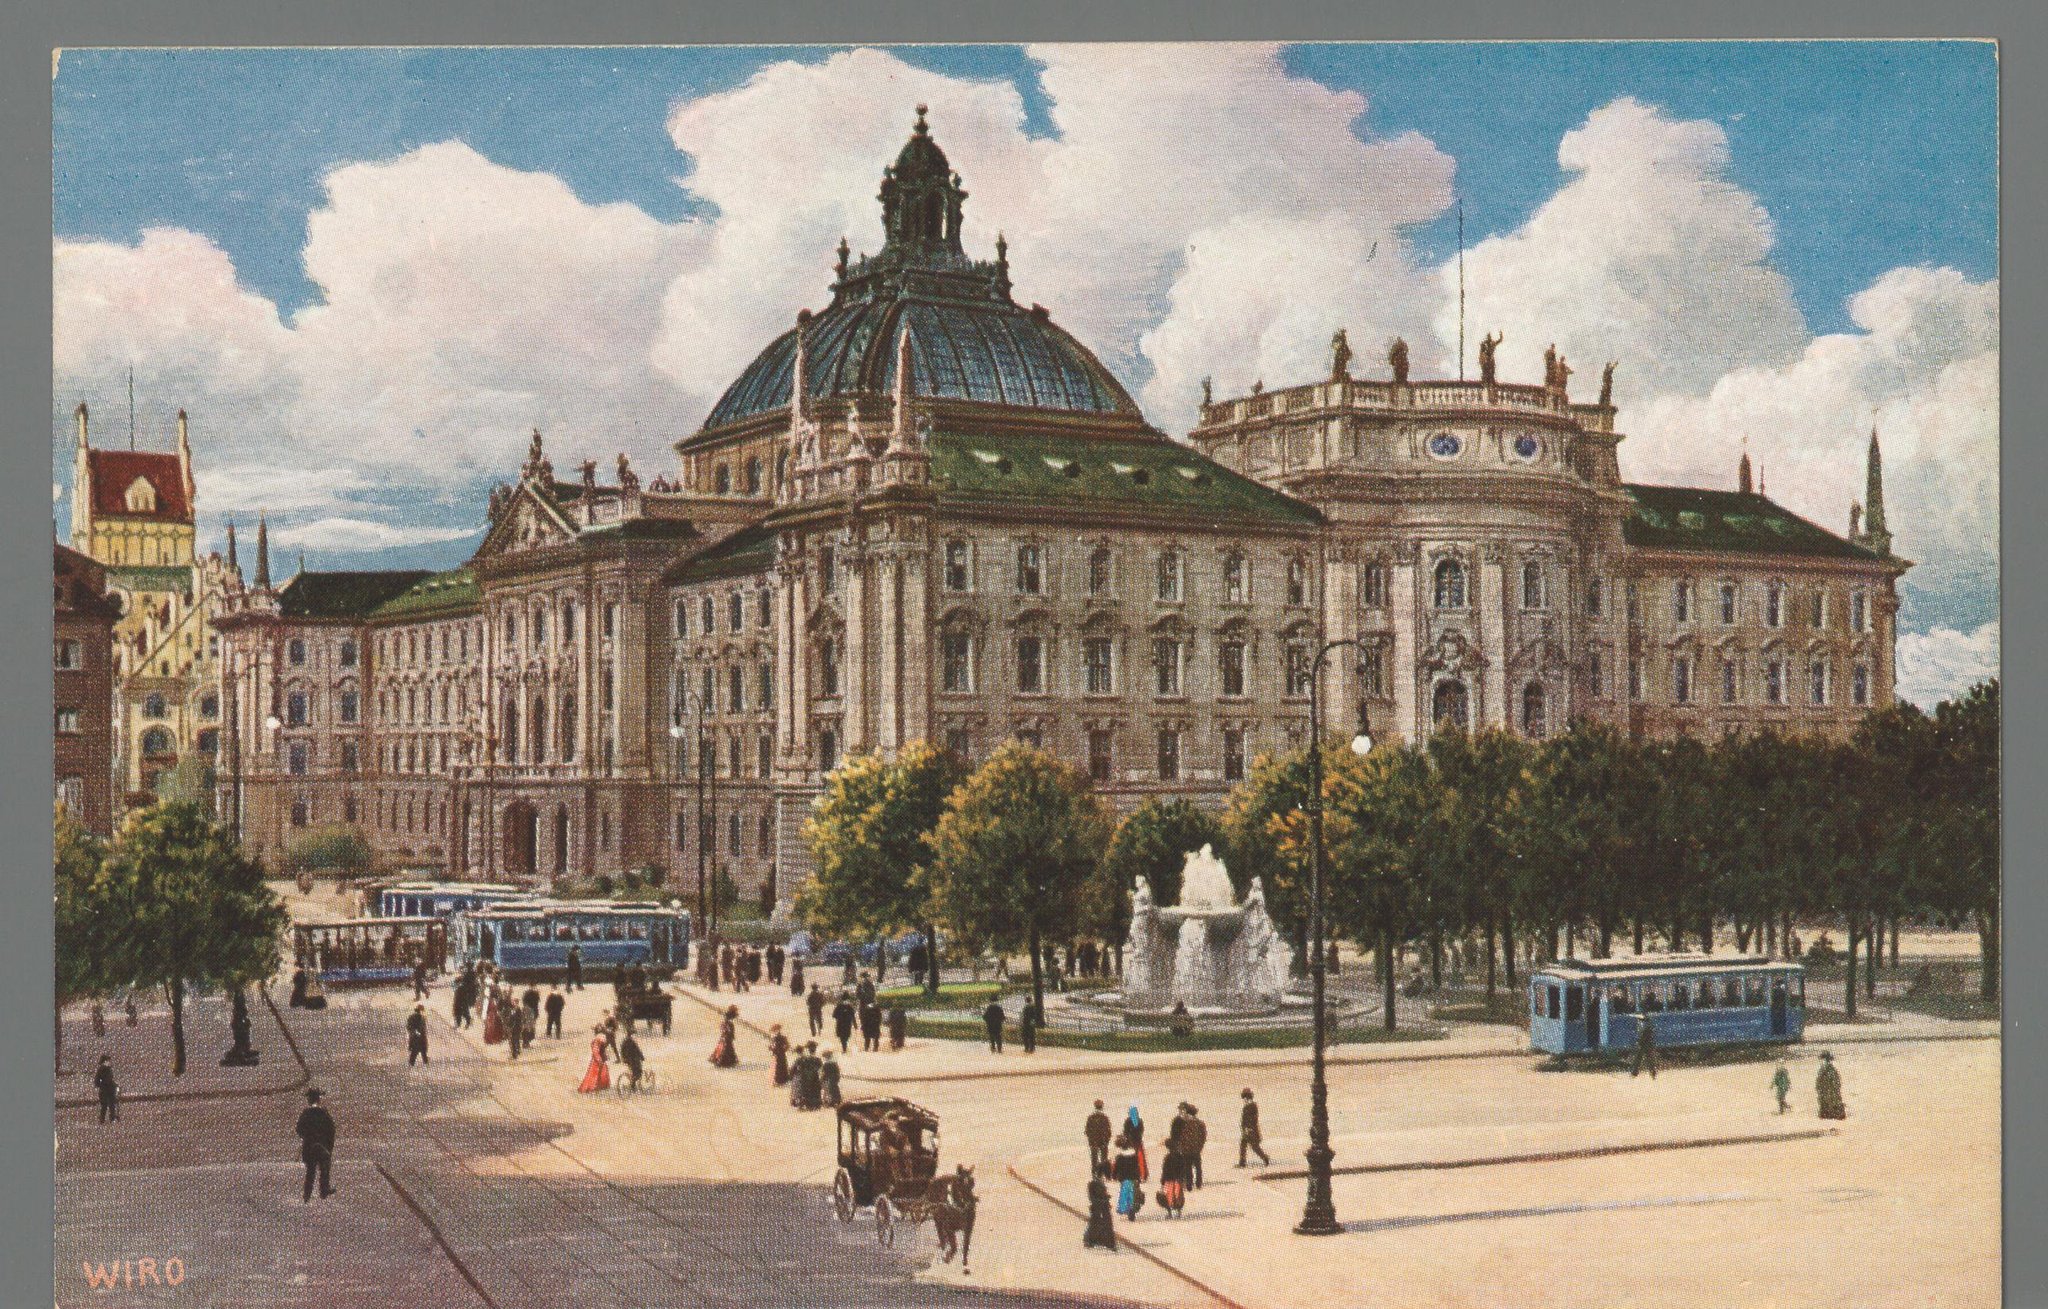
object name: ansichtkaart, prentbriefkaart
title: München, Justizpalast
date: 1905-1930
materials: cardboard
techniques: color autotype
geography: roda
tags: court building, ornamental fountain